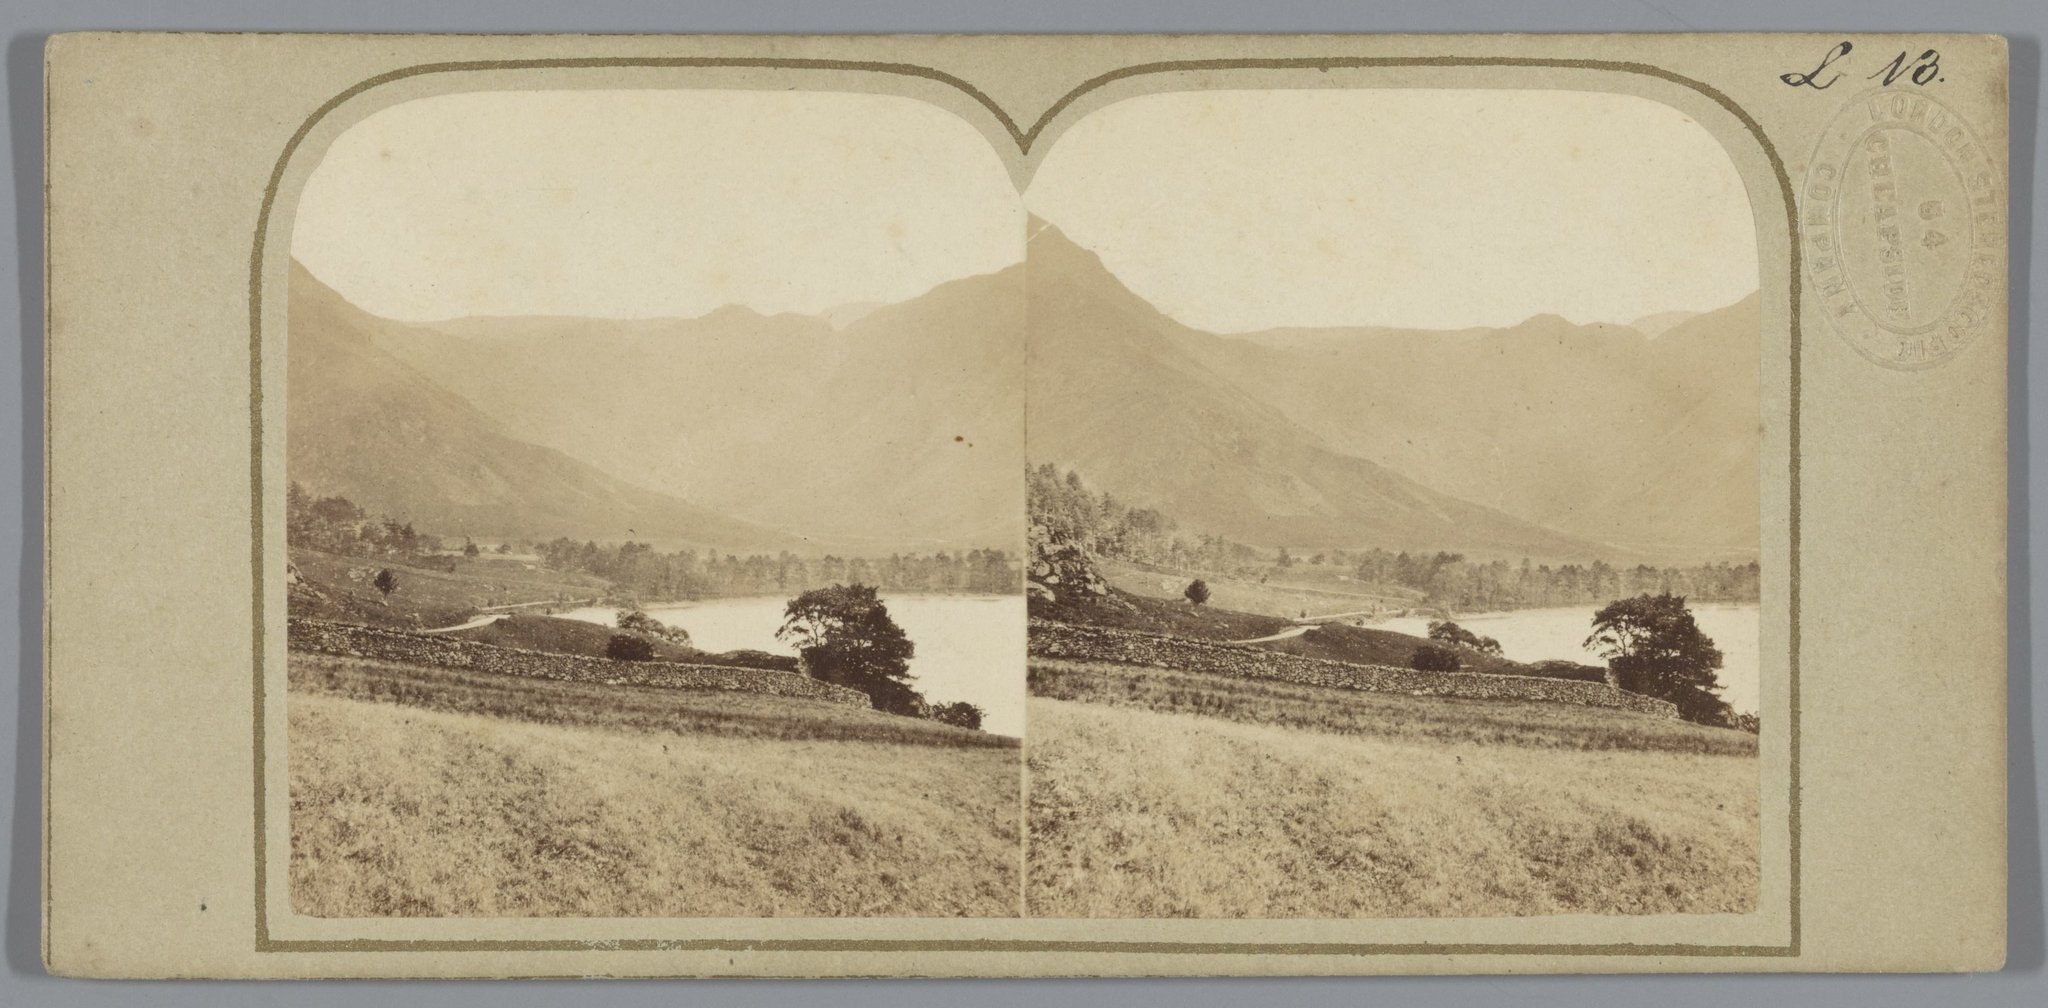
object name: stereograph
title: The English Lakes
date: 1854-1880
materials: cardboard, photographic support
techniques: albumen print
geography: buttermere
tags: lake, mountains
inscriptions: name: ‘London Stereoscopic Company 54 Cheapside’, number: ‘L N3.’